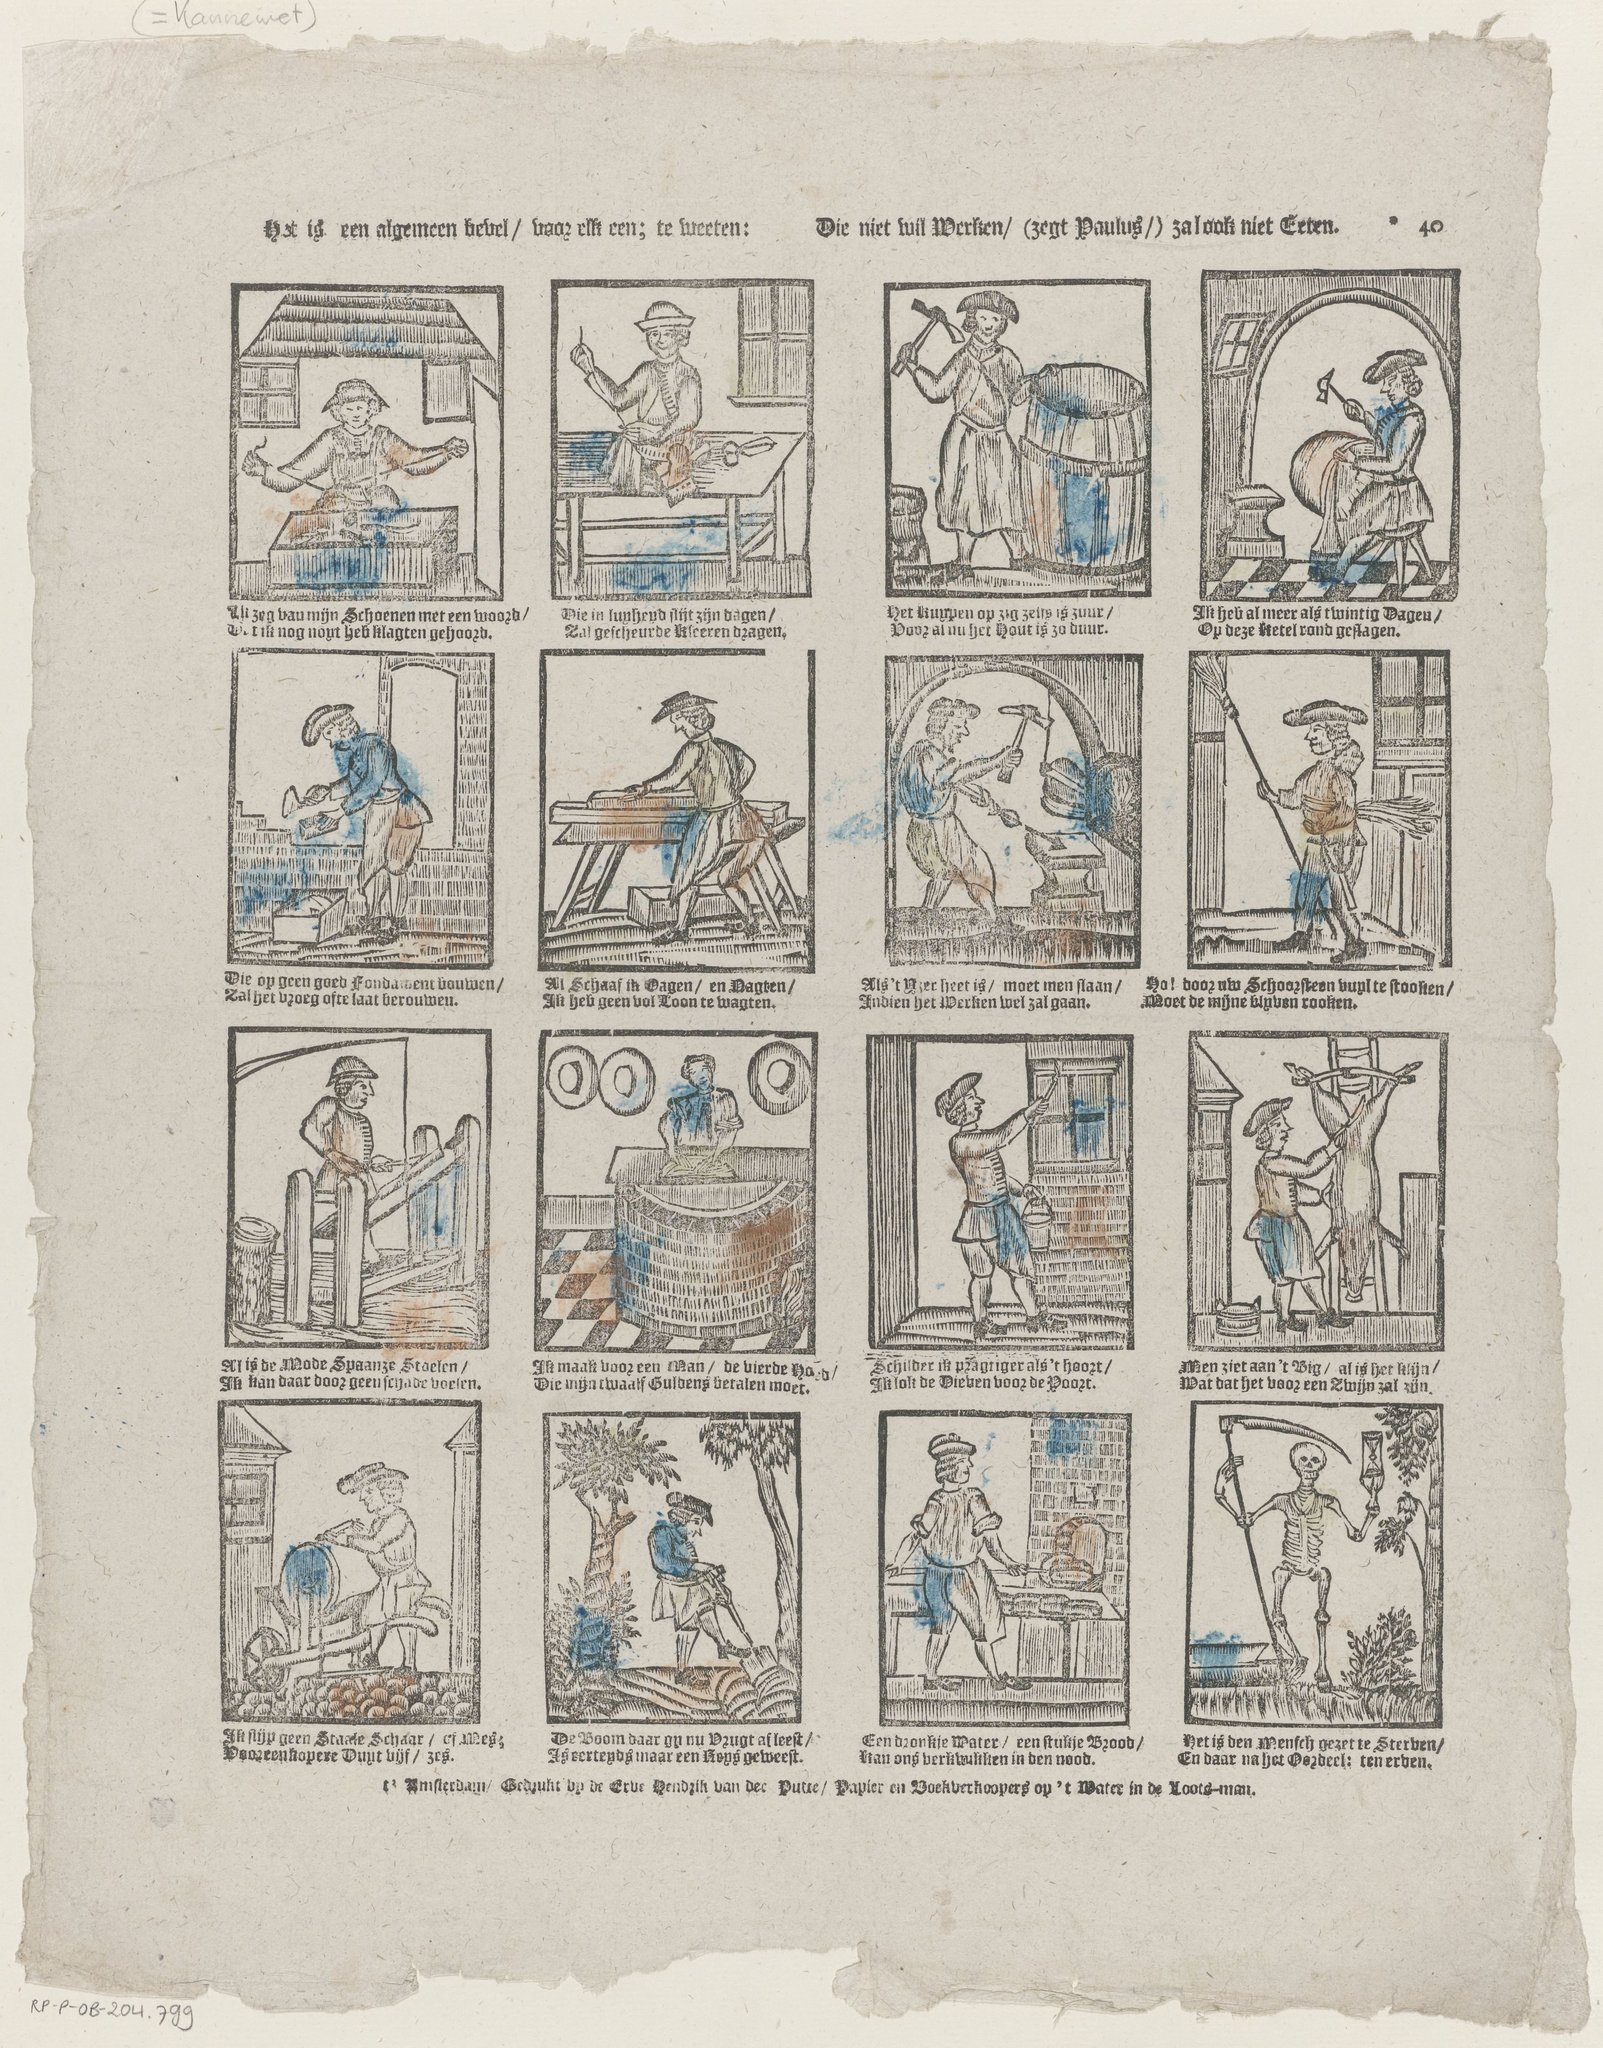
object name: print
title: Het is een algemeen bevel / voor elk een; te weeten: / Die niet wil werken / (zegt Paulus/) zal ook niet eeten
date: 1767-1793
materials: paper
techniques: colour, letterpress printing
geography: amsterdam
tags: craft-production, skilled handiwork, mason at work, tailor, dressmaker, crafts and industries, shoe-maker, cobbler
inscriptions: collector's mark: Lugt 2760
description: Blad met 16 voorstellingen van ambachtslieden en beroepen, zoals schoenmaker, kleermaker en metselaar. Onder elke afbeelding een tweeregelig vers. Genummerd rechtsboven: *40.